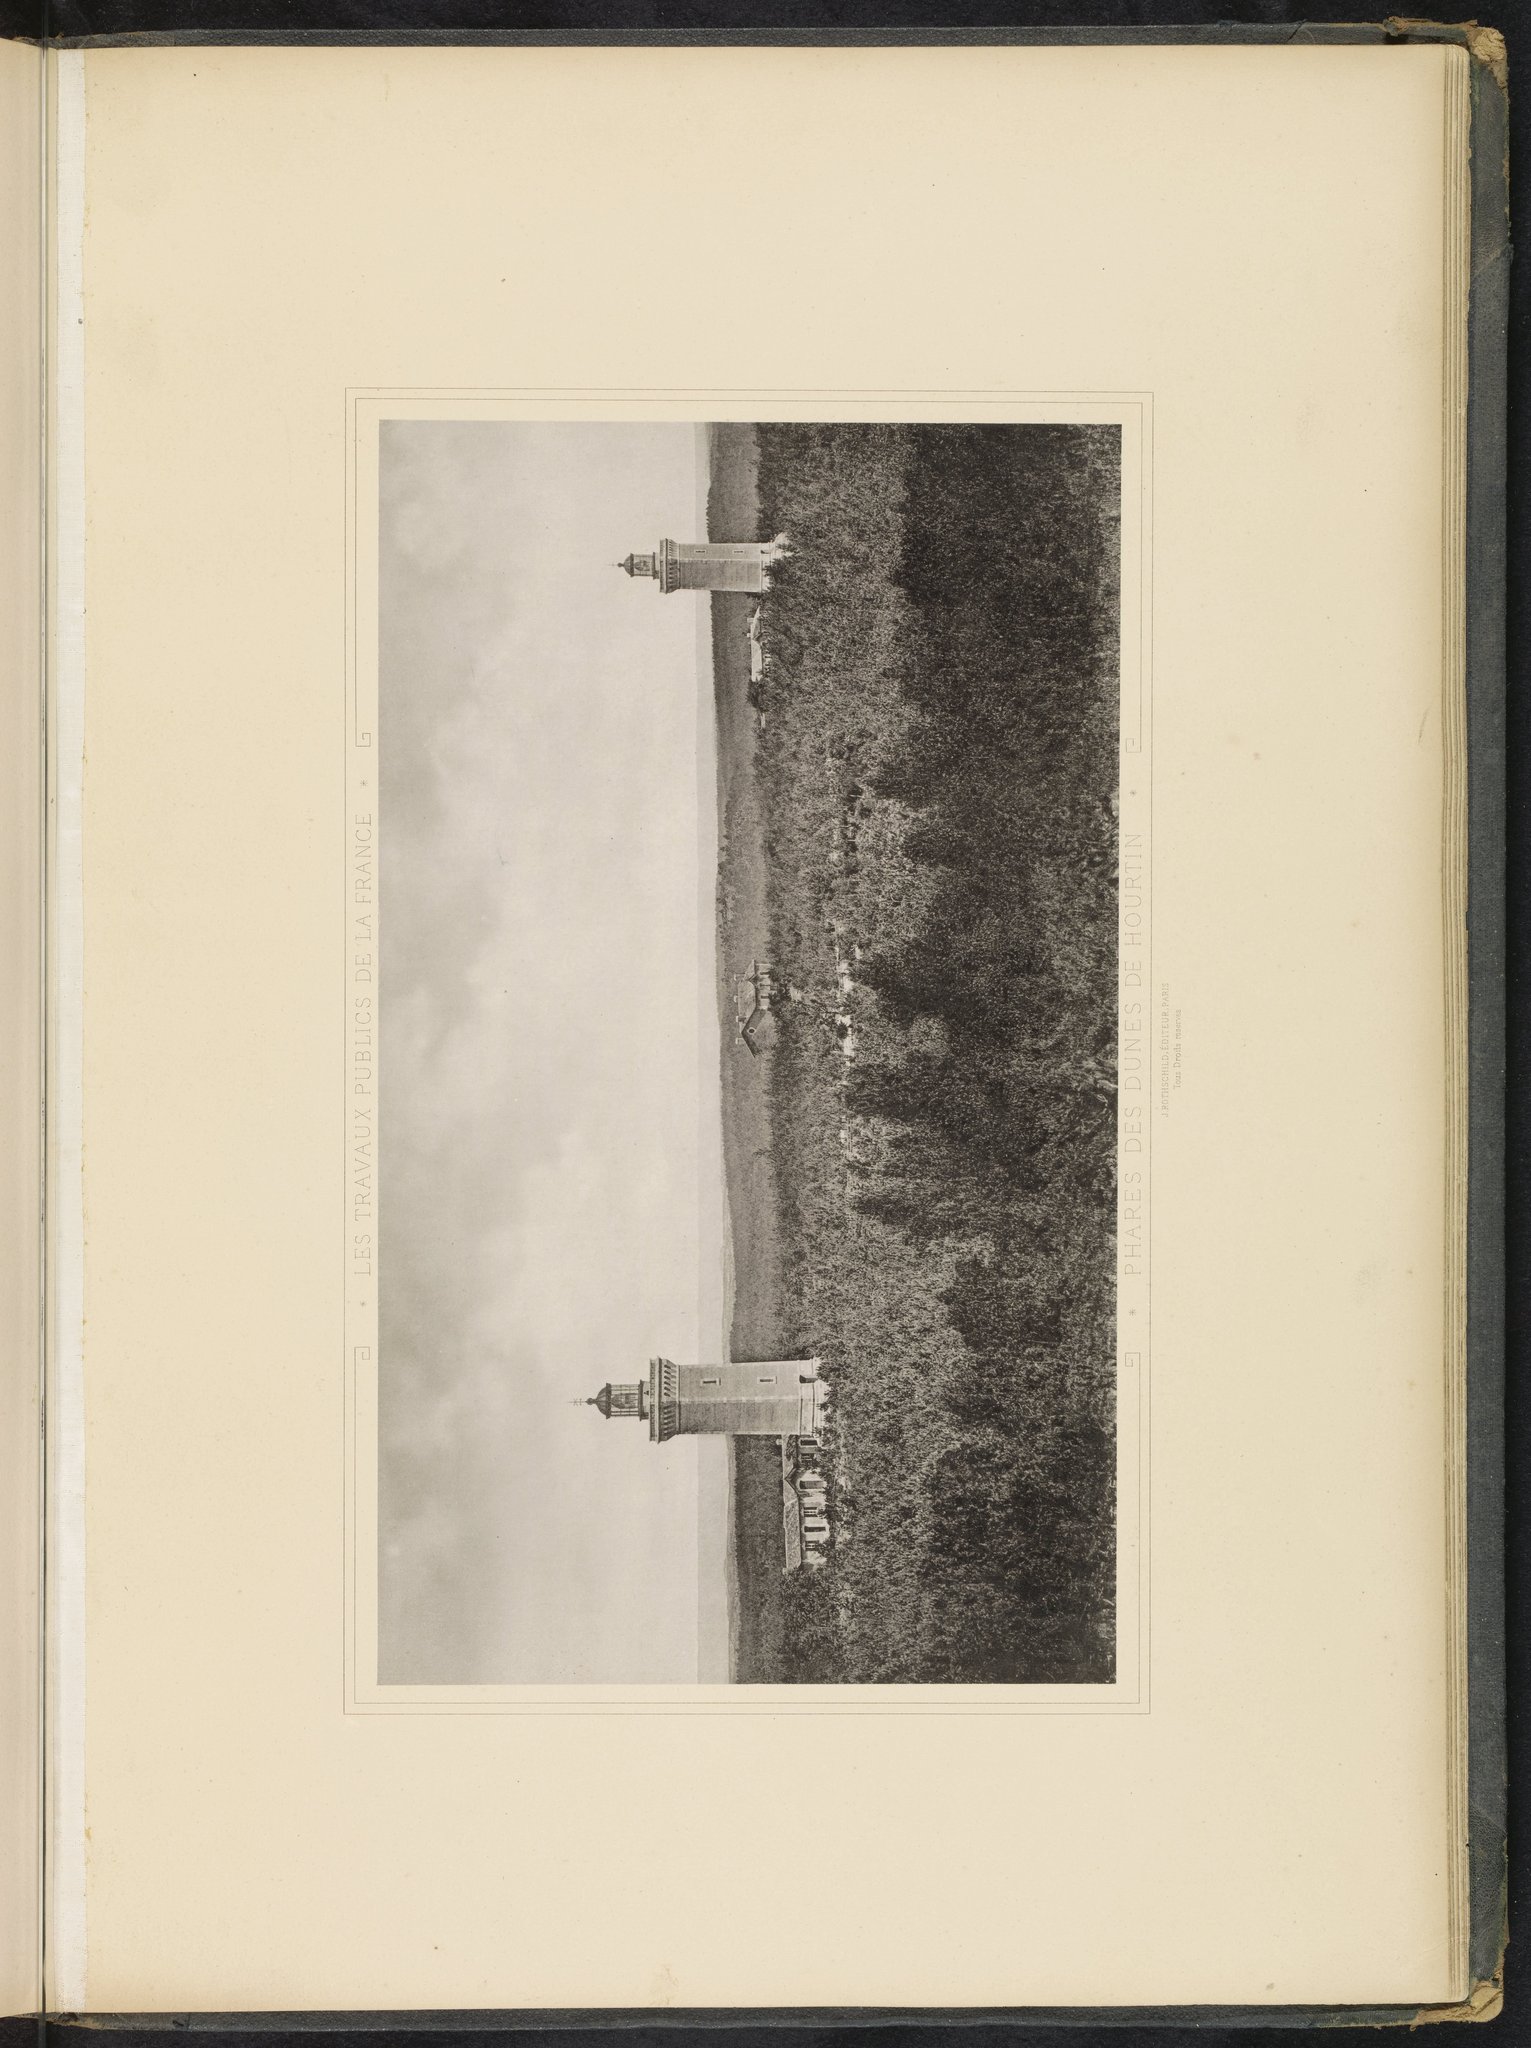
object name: page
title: Gezicht op de vuurtorens van Hourtin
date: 1873-1883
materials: paper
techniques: photograph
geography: france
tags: lighthouse, lightship, dune coast